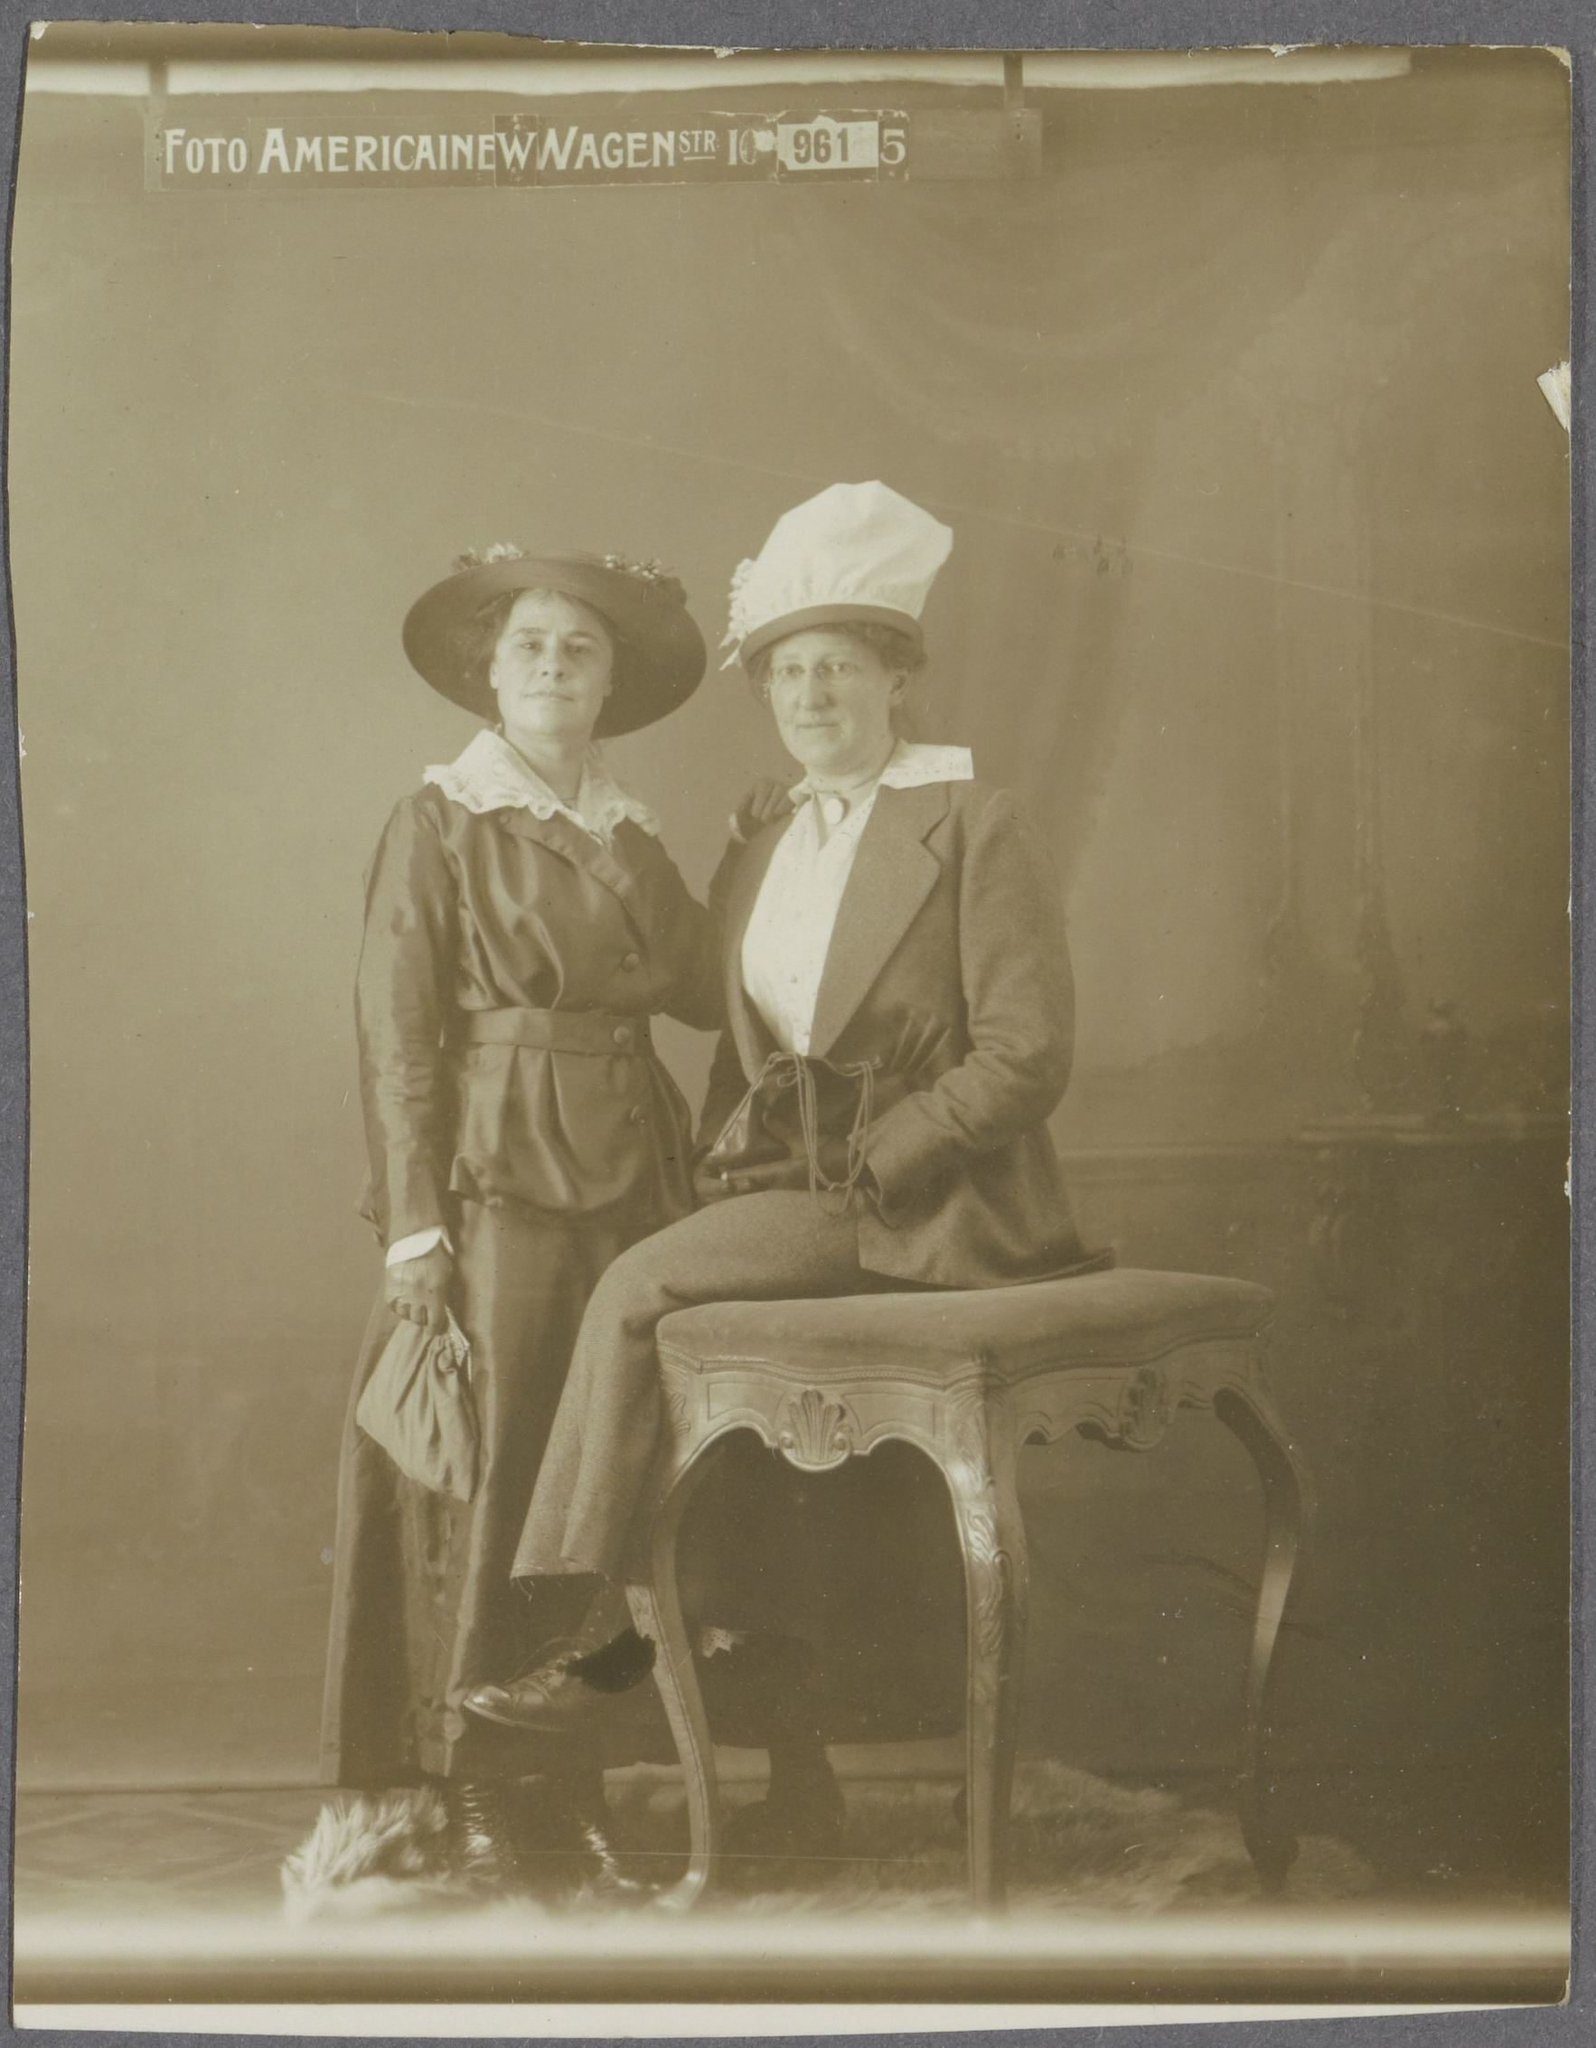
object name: album leaf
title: Portret van twee vrouwen met hoeden, de een staand, de ander zittend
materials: paper, cardboard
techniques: gelatin silver print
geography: the hague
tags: adult woman, studio requisites ~ photographer, historical persons, head-gear: hat, the hague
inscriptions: address: ‘Wagenstraat 10’, number: ‘961 5’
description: Onderdeel van Fotoalbum met portretten vervaardigd door Nederlandse studio's waaronder automaatfoto's.